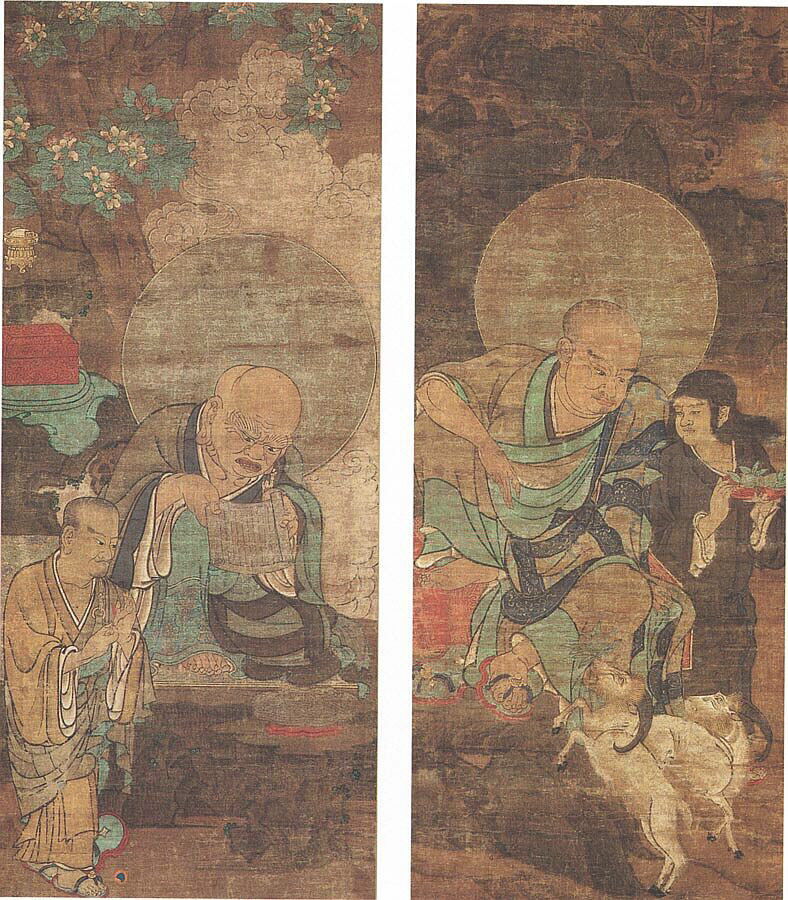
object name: hanging scroll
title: Rakan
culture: japanese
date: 1333-1392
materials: ink, silk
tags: animals,men